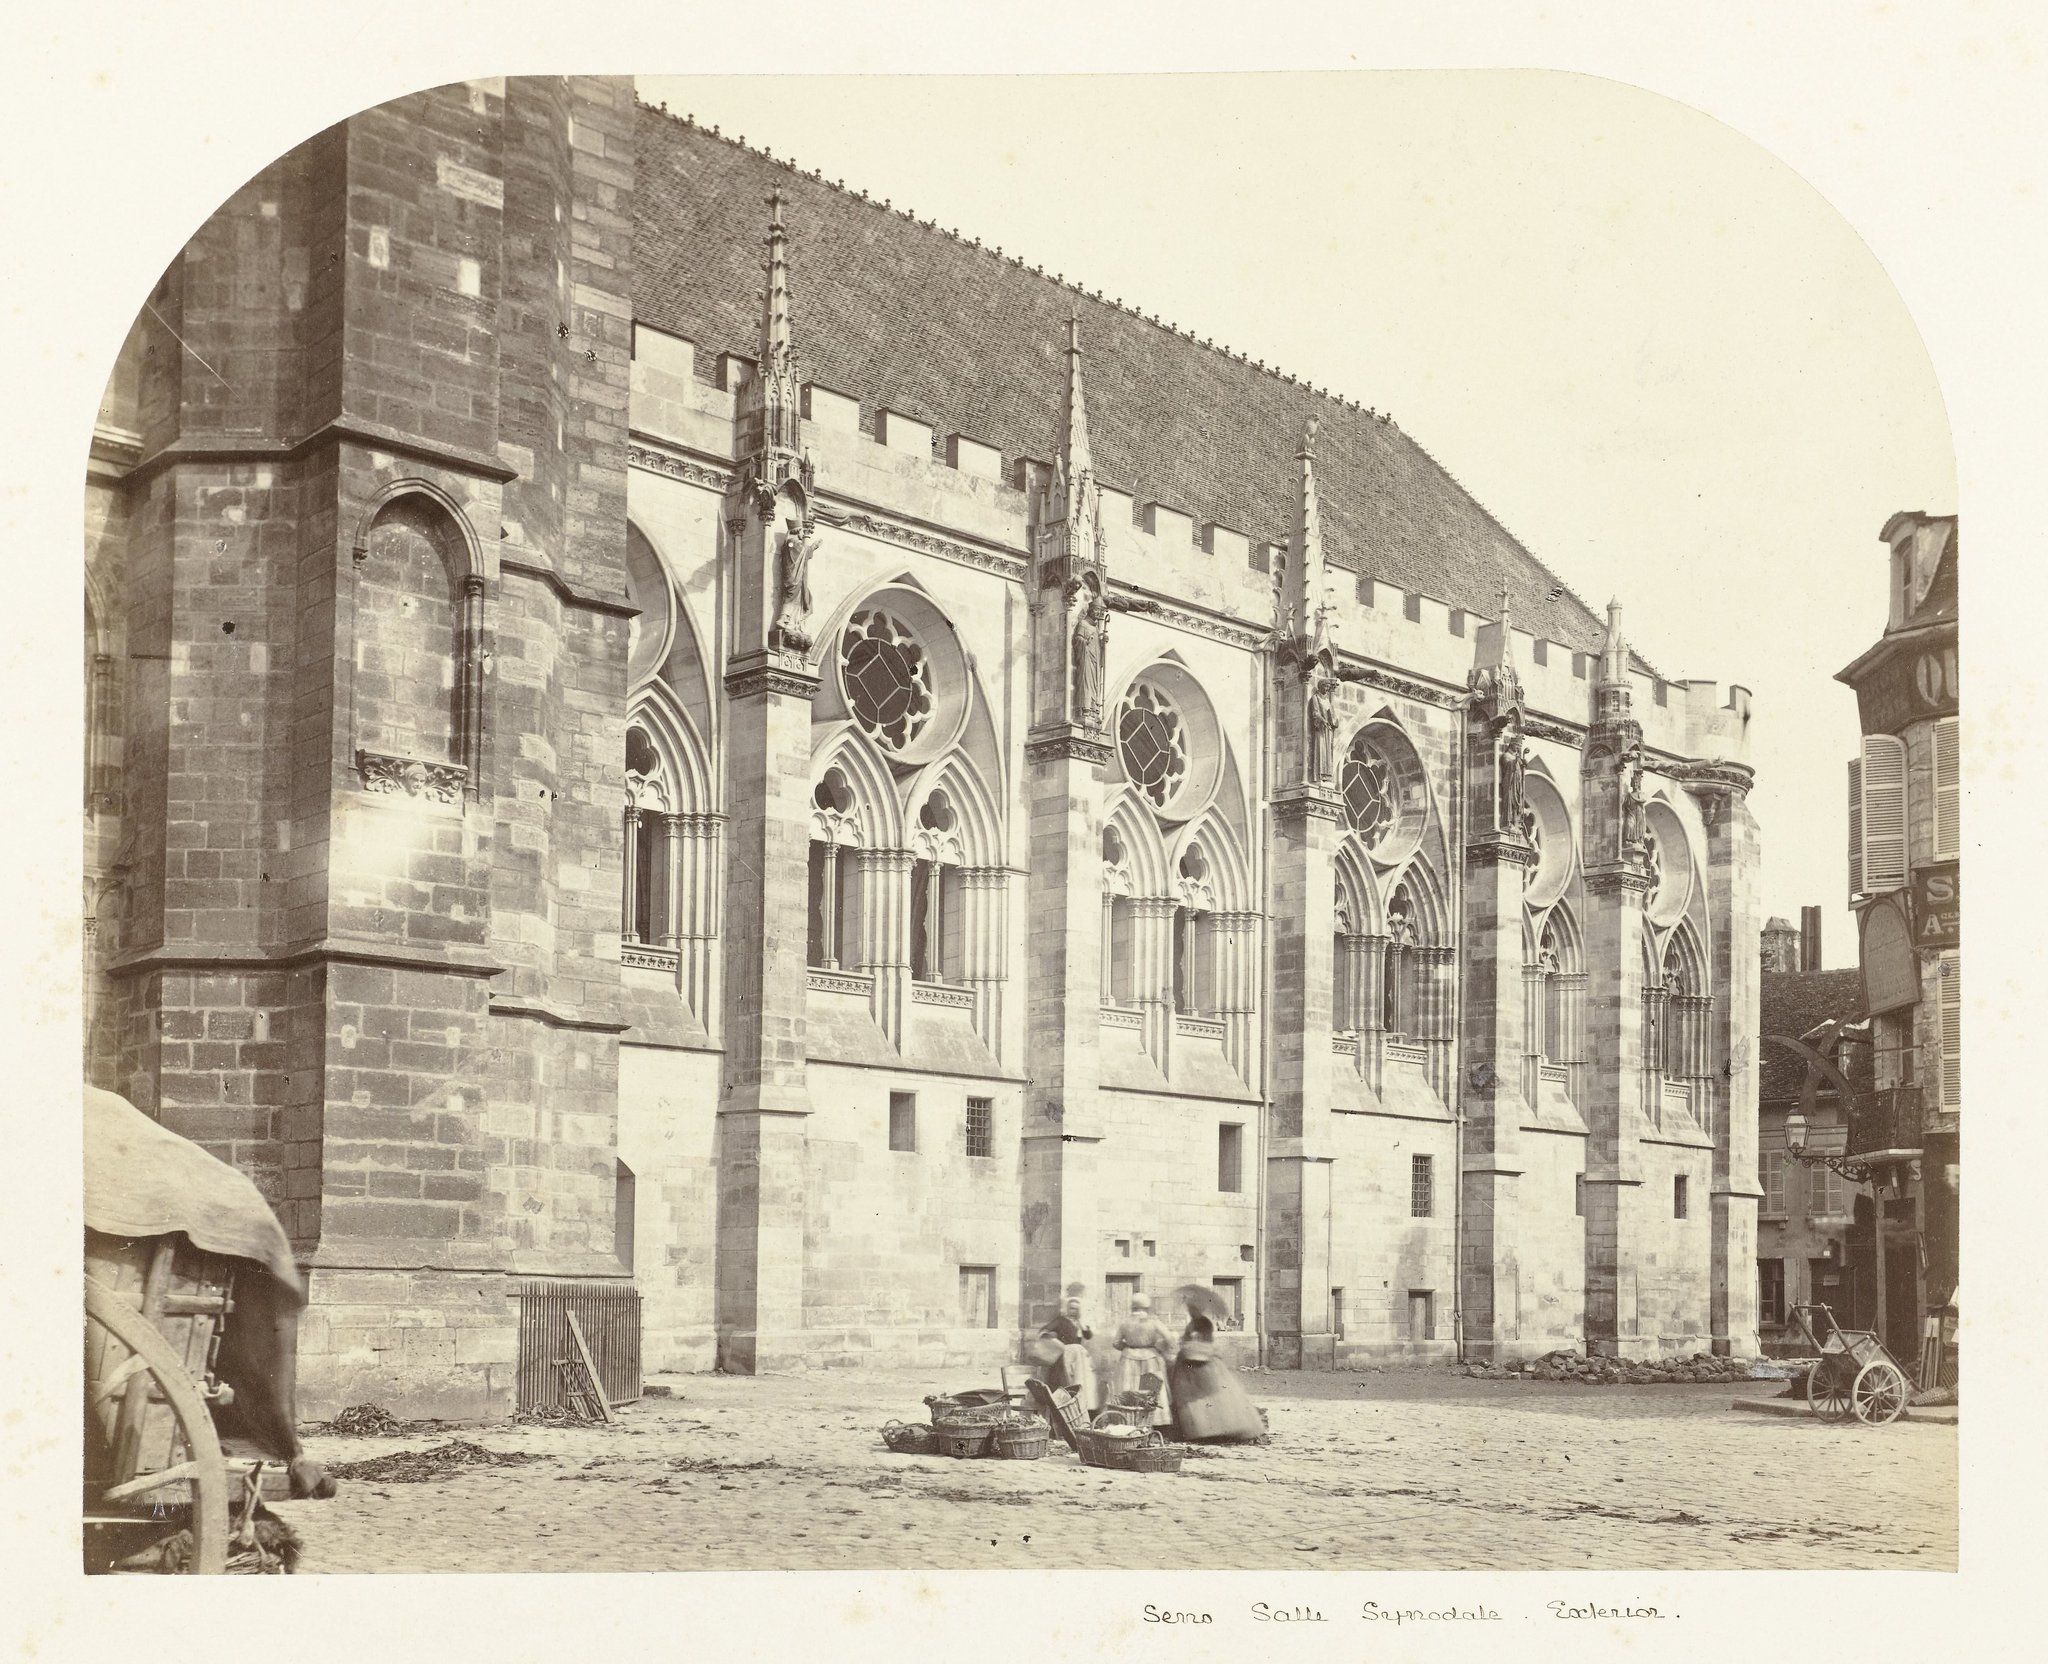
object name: photograph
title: Senno Salle Seprodale Exterior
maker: Anonymous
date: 1858-1861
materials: cardboard, paper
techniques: albumen print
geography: london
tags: parts of church exterior and annexes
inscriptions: address: ‘168 NEW BOND ST.’, monogram: ‘APA’